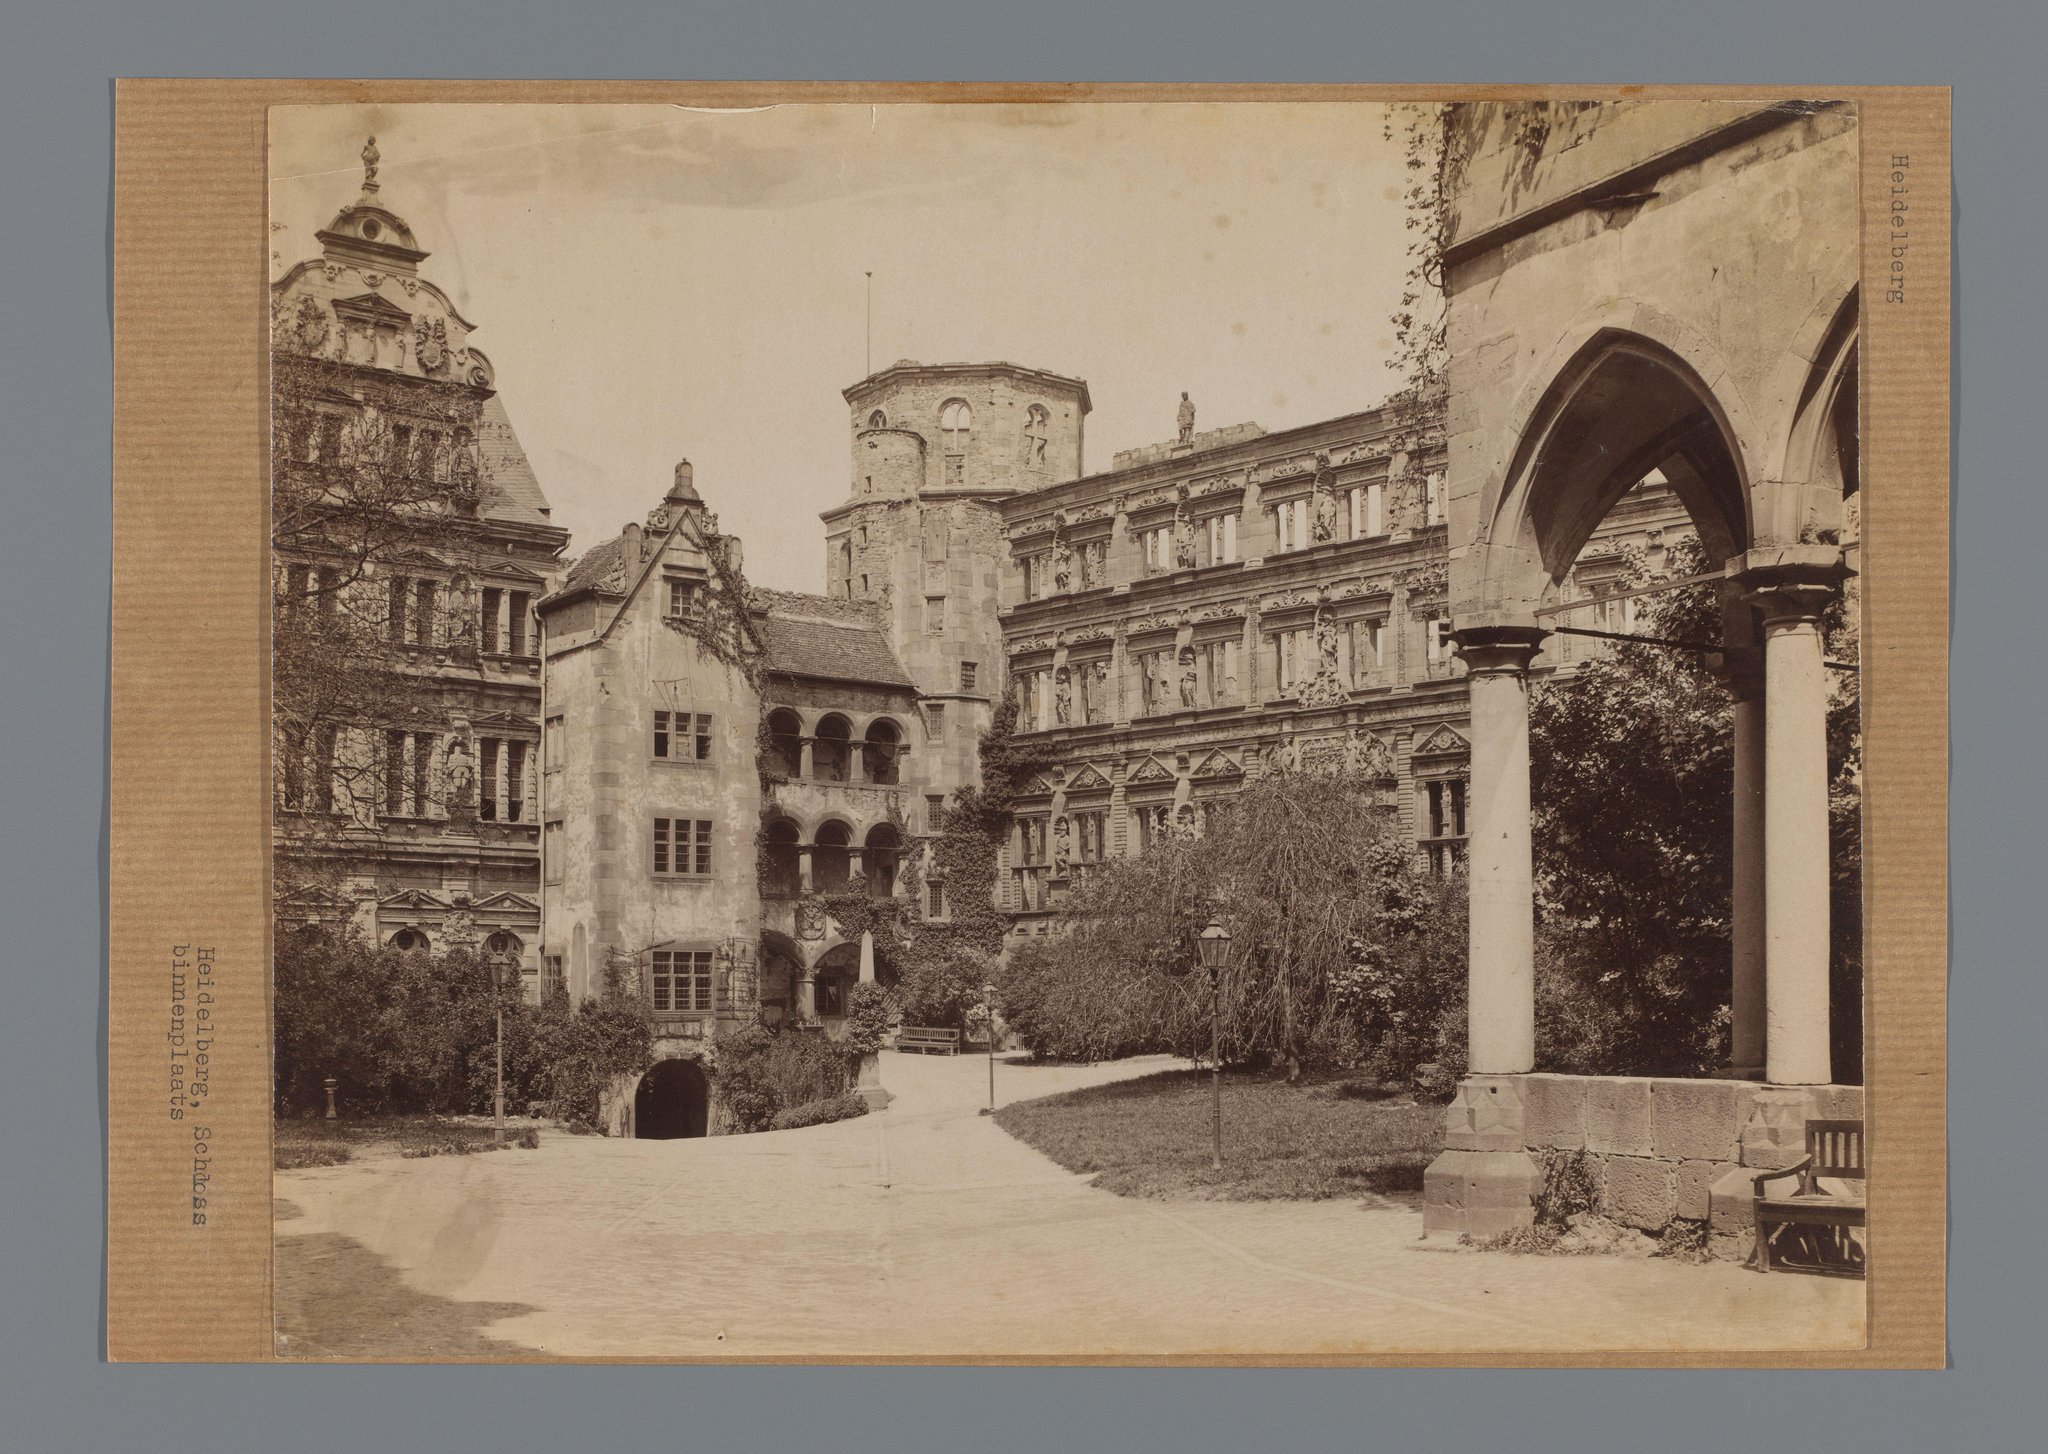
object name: photograph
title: Heidelberg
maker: Anonymous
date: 1850-1900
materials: photographic support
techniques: albumen print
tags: heidelberg